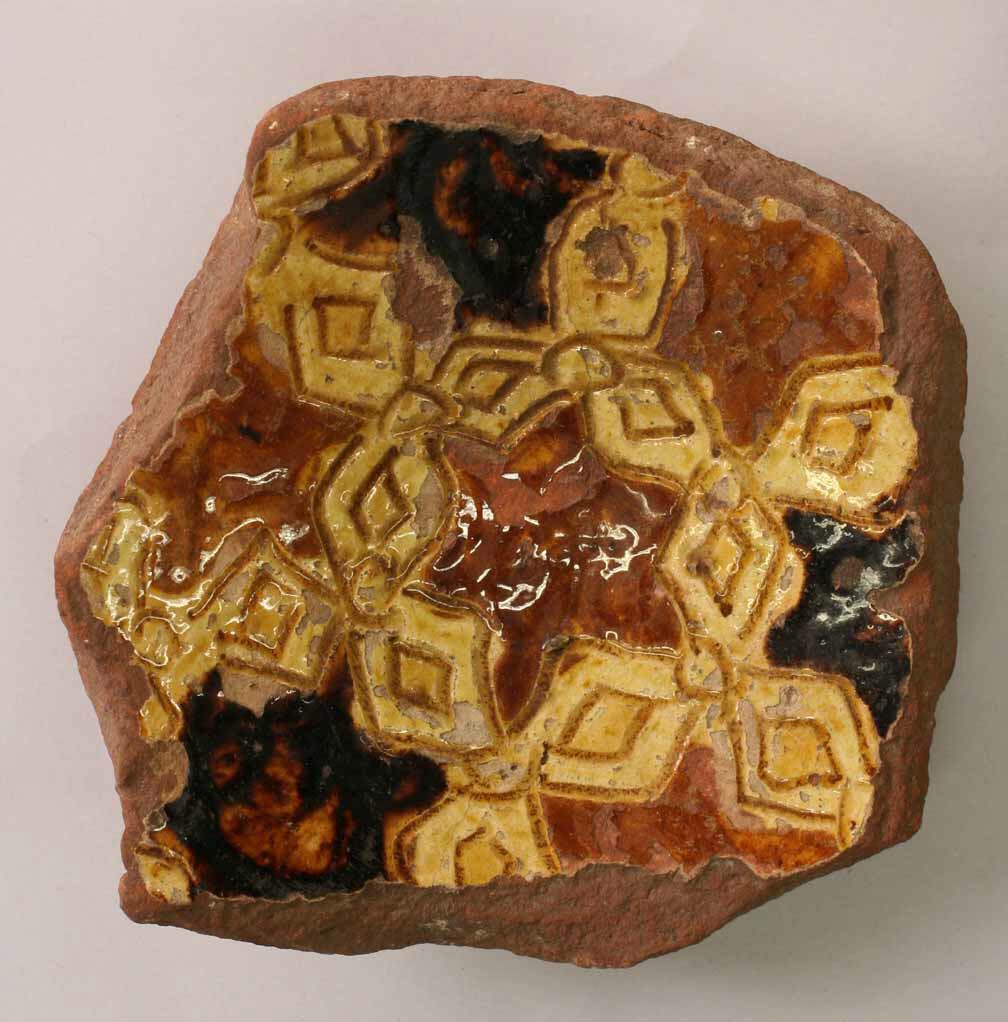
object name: fragment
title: Fragment of a Bowl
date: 1401-1500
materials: earthenware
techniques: glazing, incising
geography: egypt